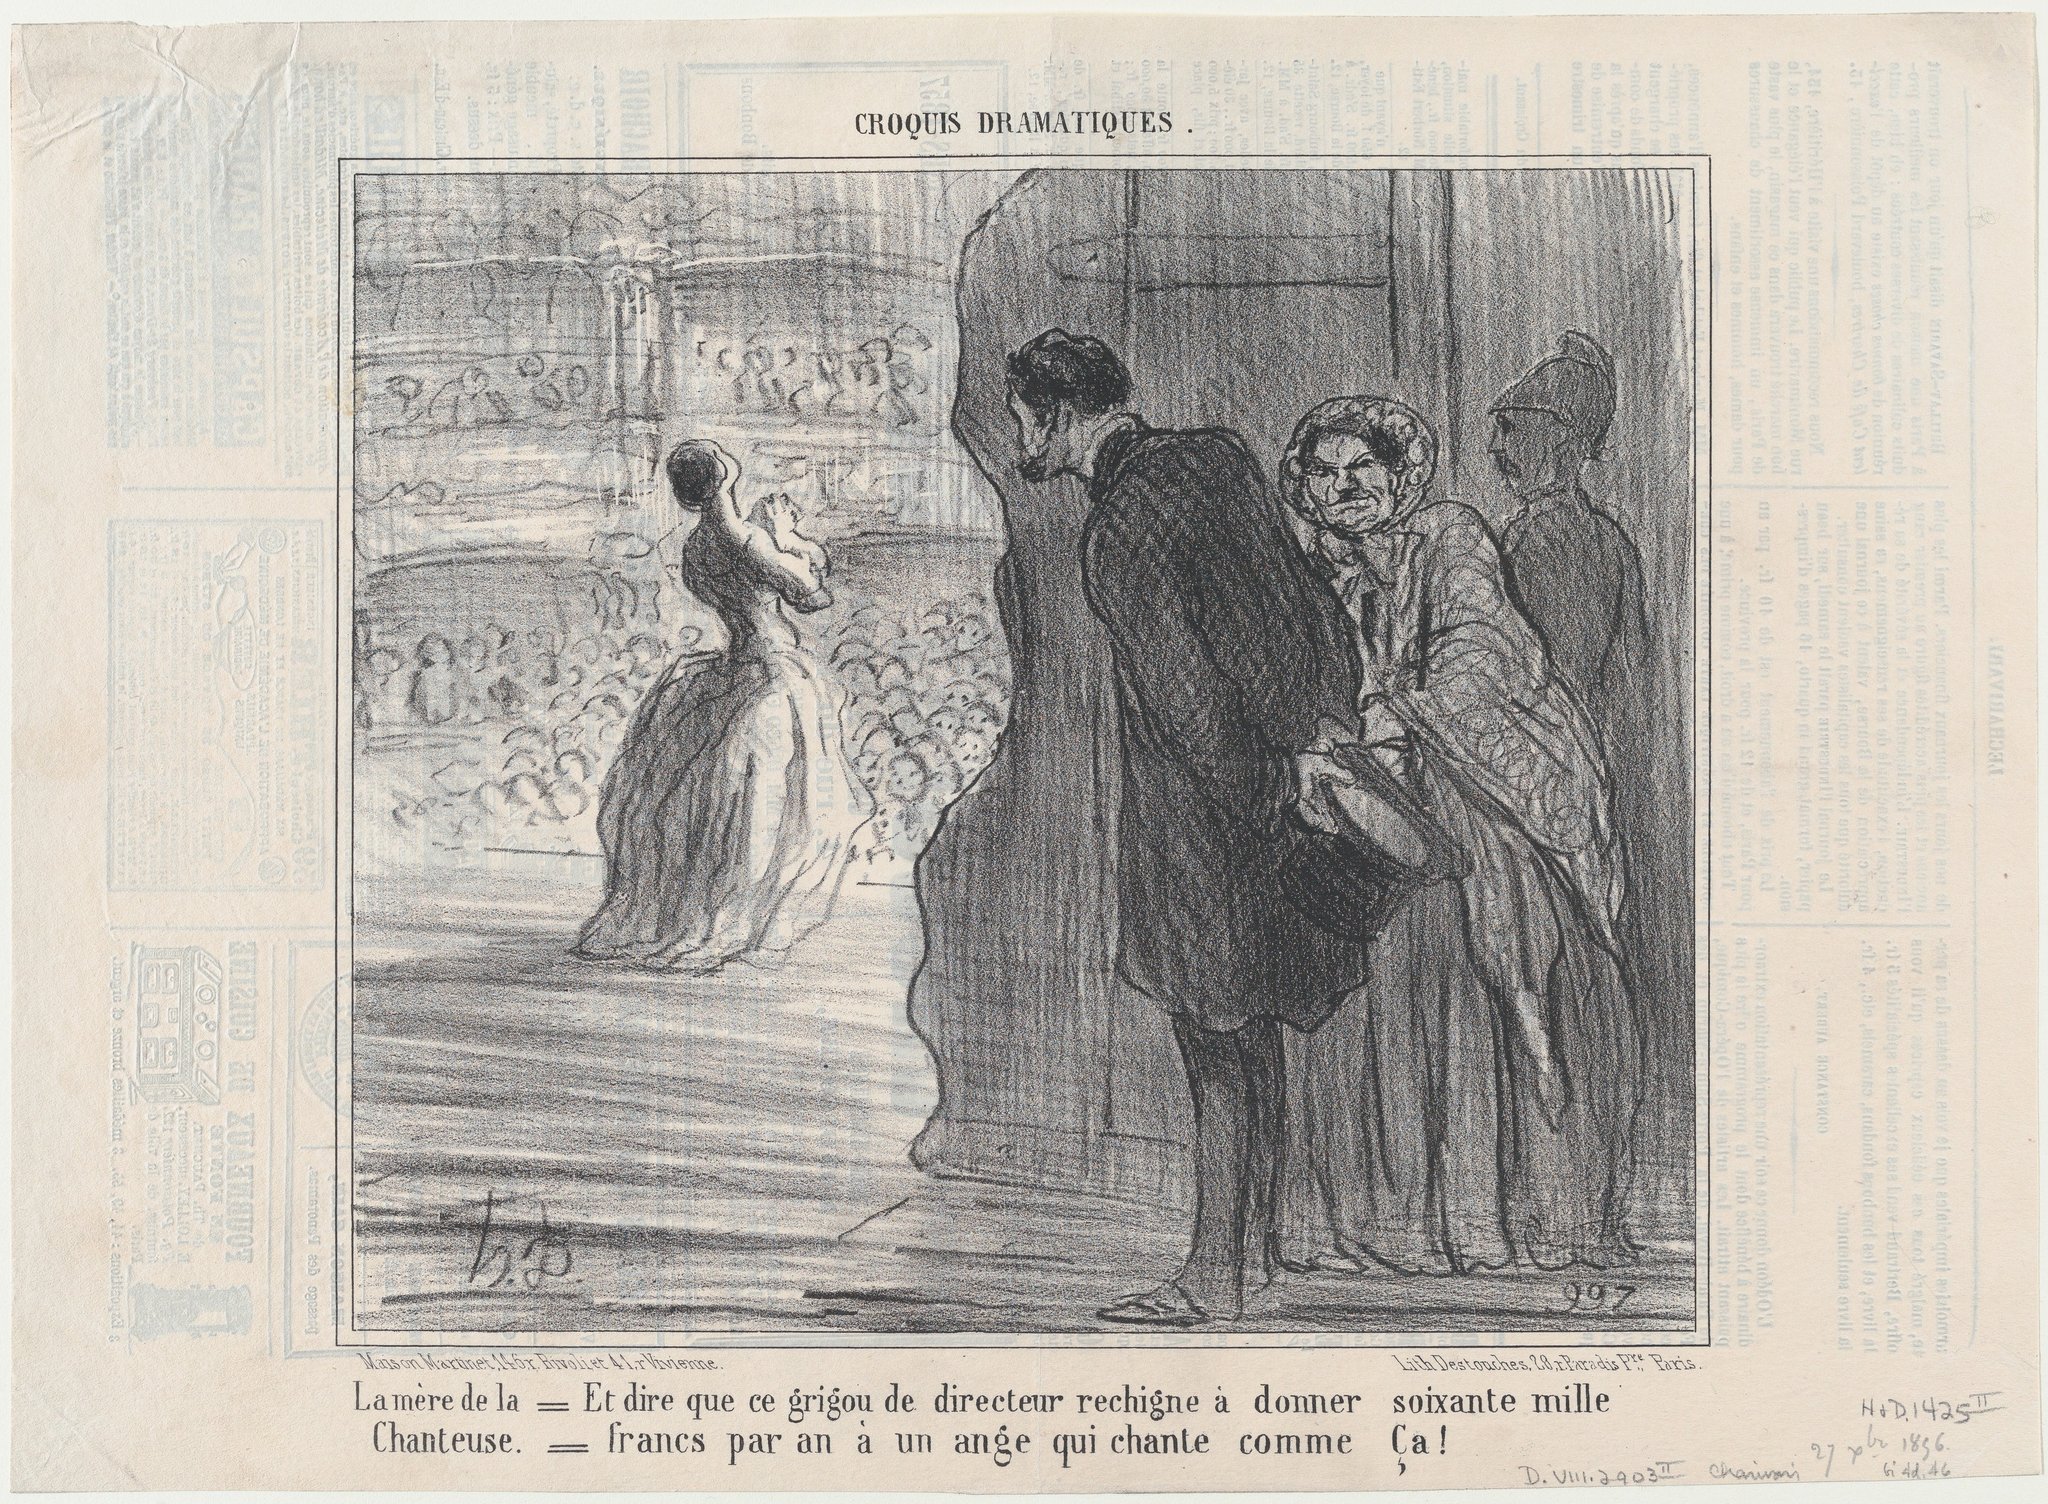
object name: print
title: La mère de la chanteuse, from Croquis Dramatiques, published in Le Charivari, december 27, 1856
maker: honoré daumier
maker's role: artist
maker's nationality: french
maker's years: 1808-1879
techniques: lithograph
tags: men,women,singing,spectators